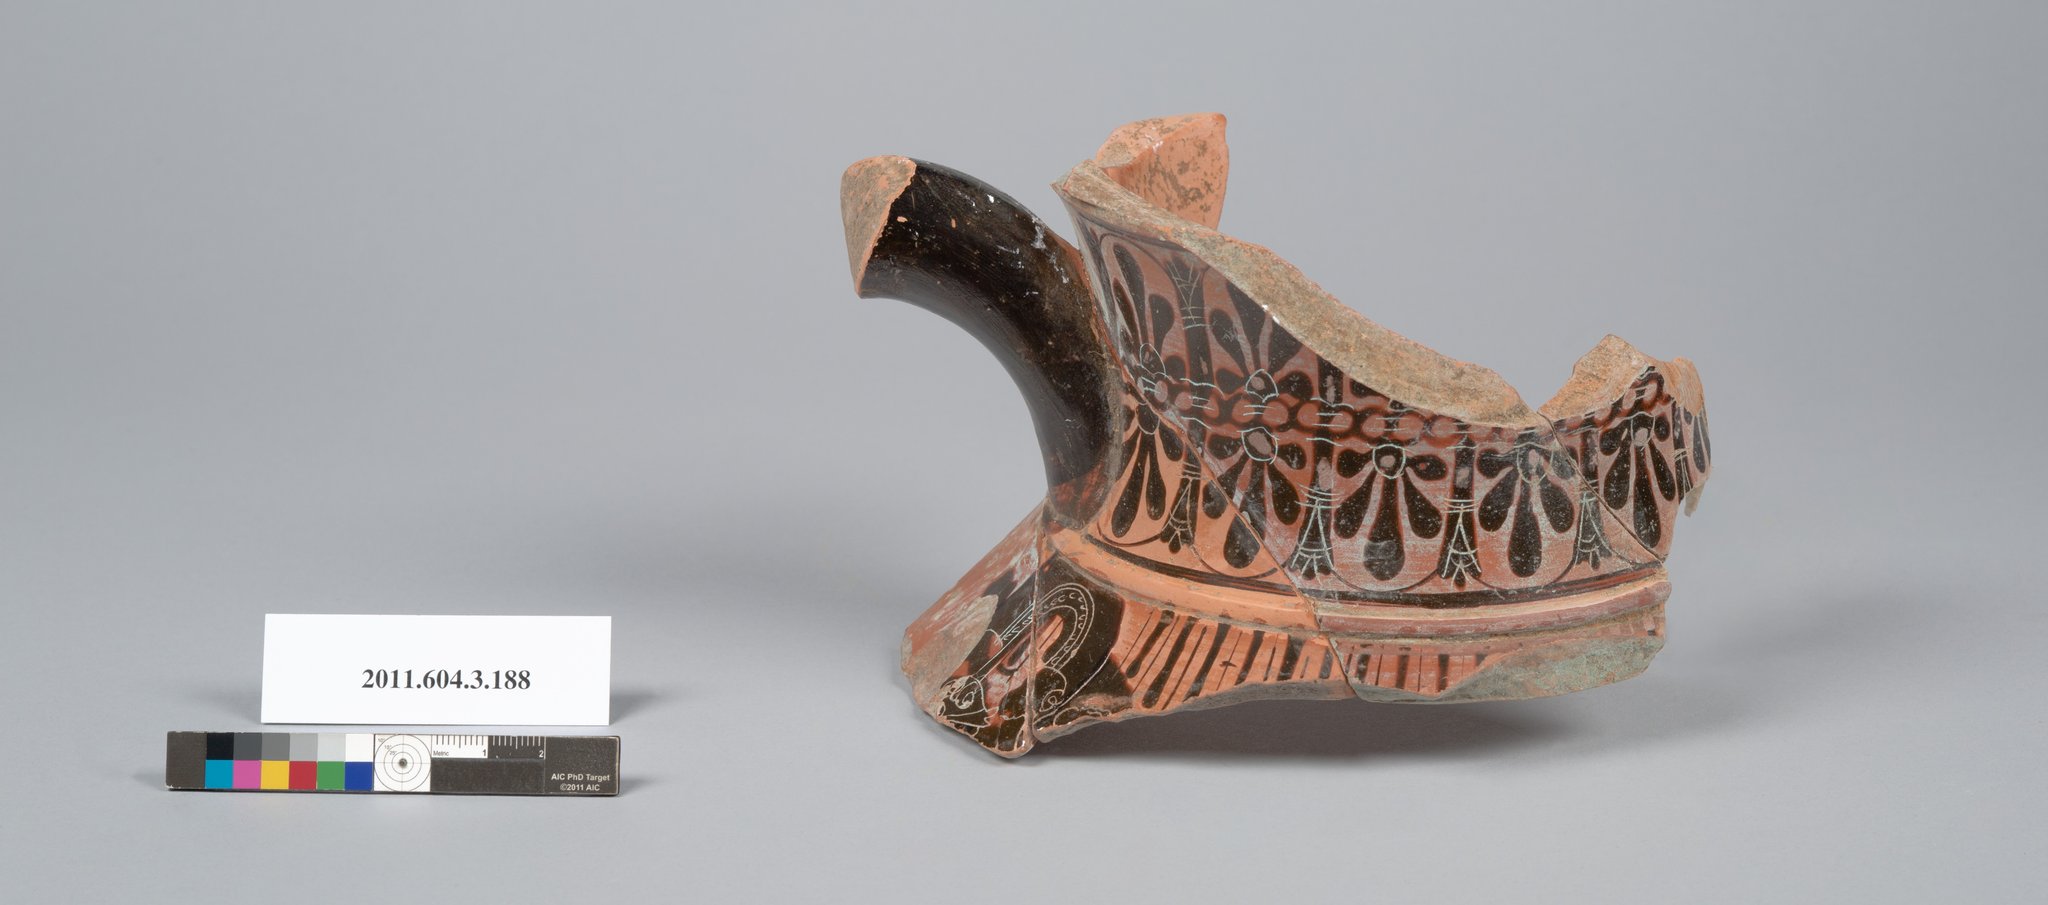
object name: neck amphora fragment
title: Terracotta fragment of a neck-amphora (jar)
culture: greek, attic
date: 525-501 BCE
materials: terracotta